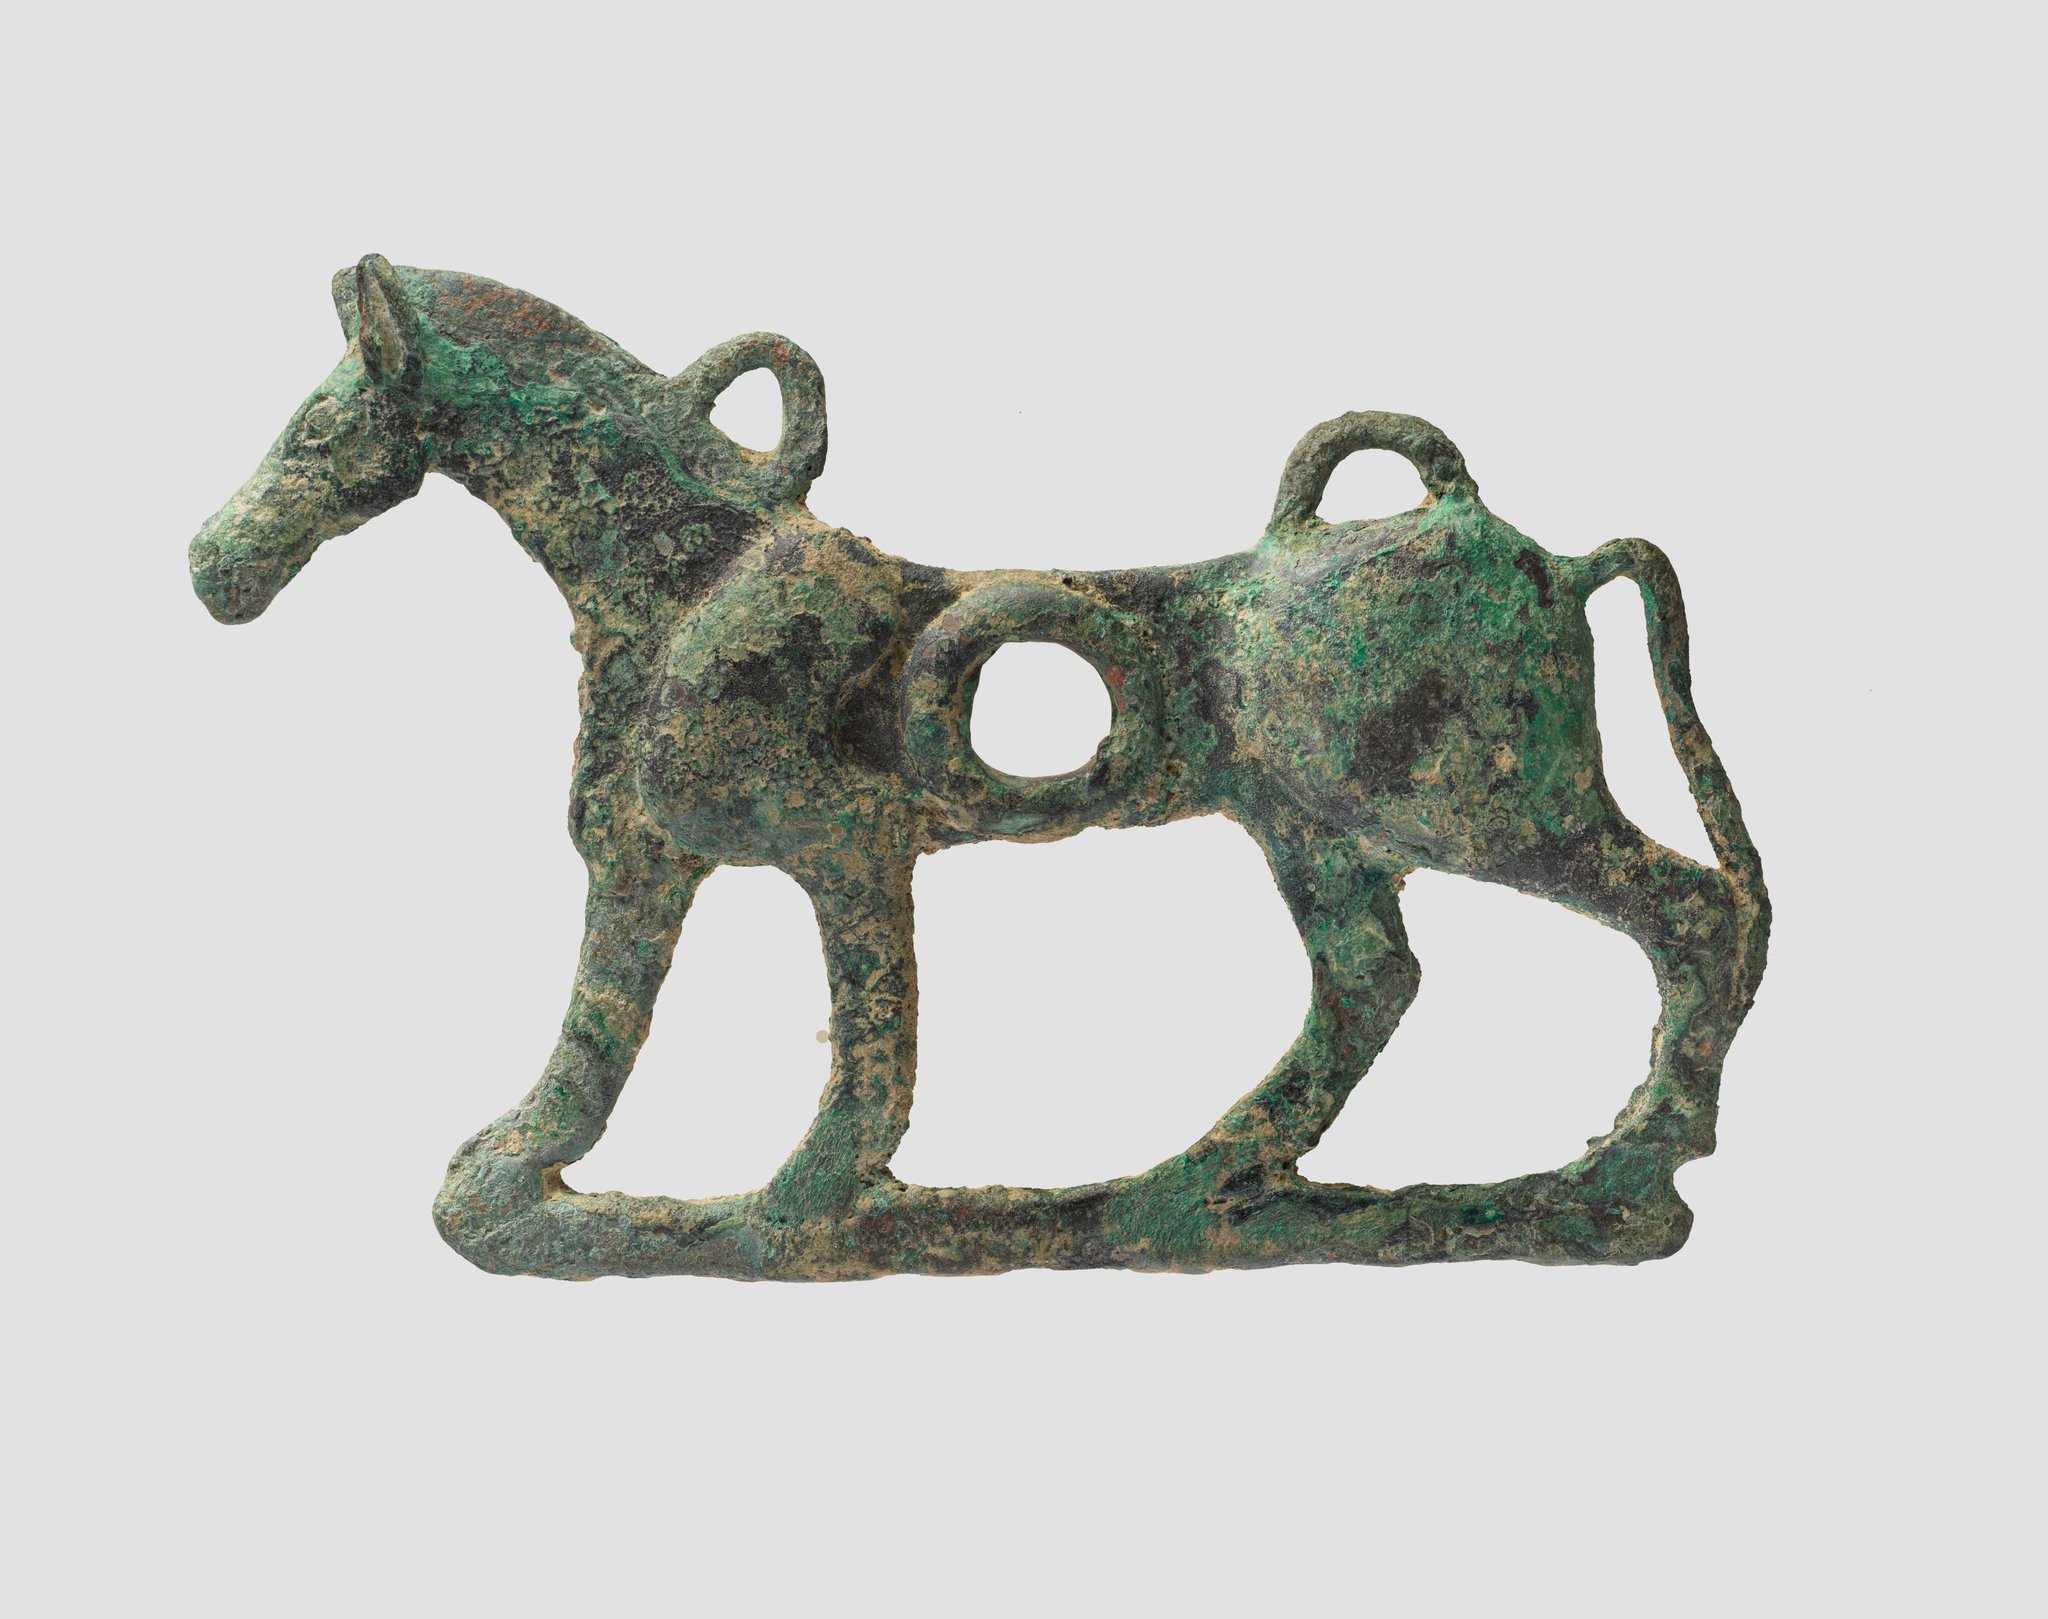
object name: horse bit cheekpiece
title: Horse bit cheekpiece in form of a striding horse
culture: iranian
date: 800-601 BCE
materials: bronze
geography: iran, probably from luristan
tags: horses